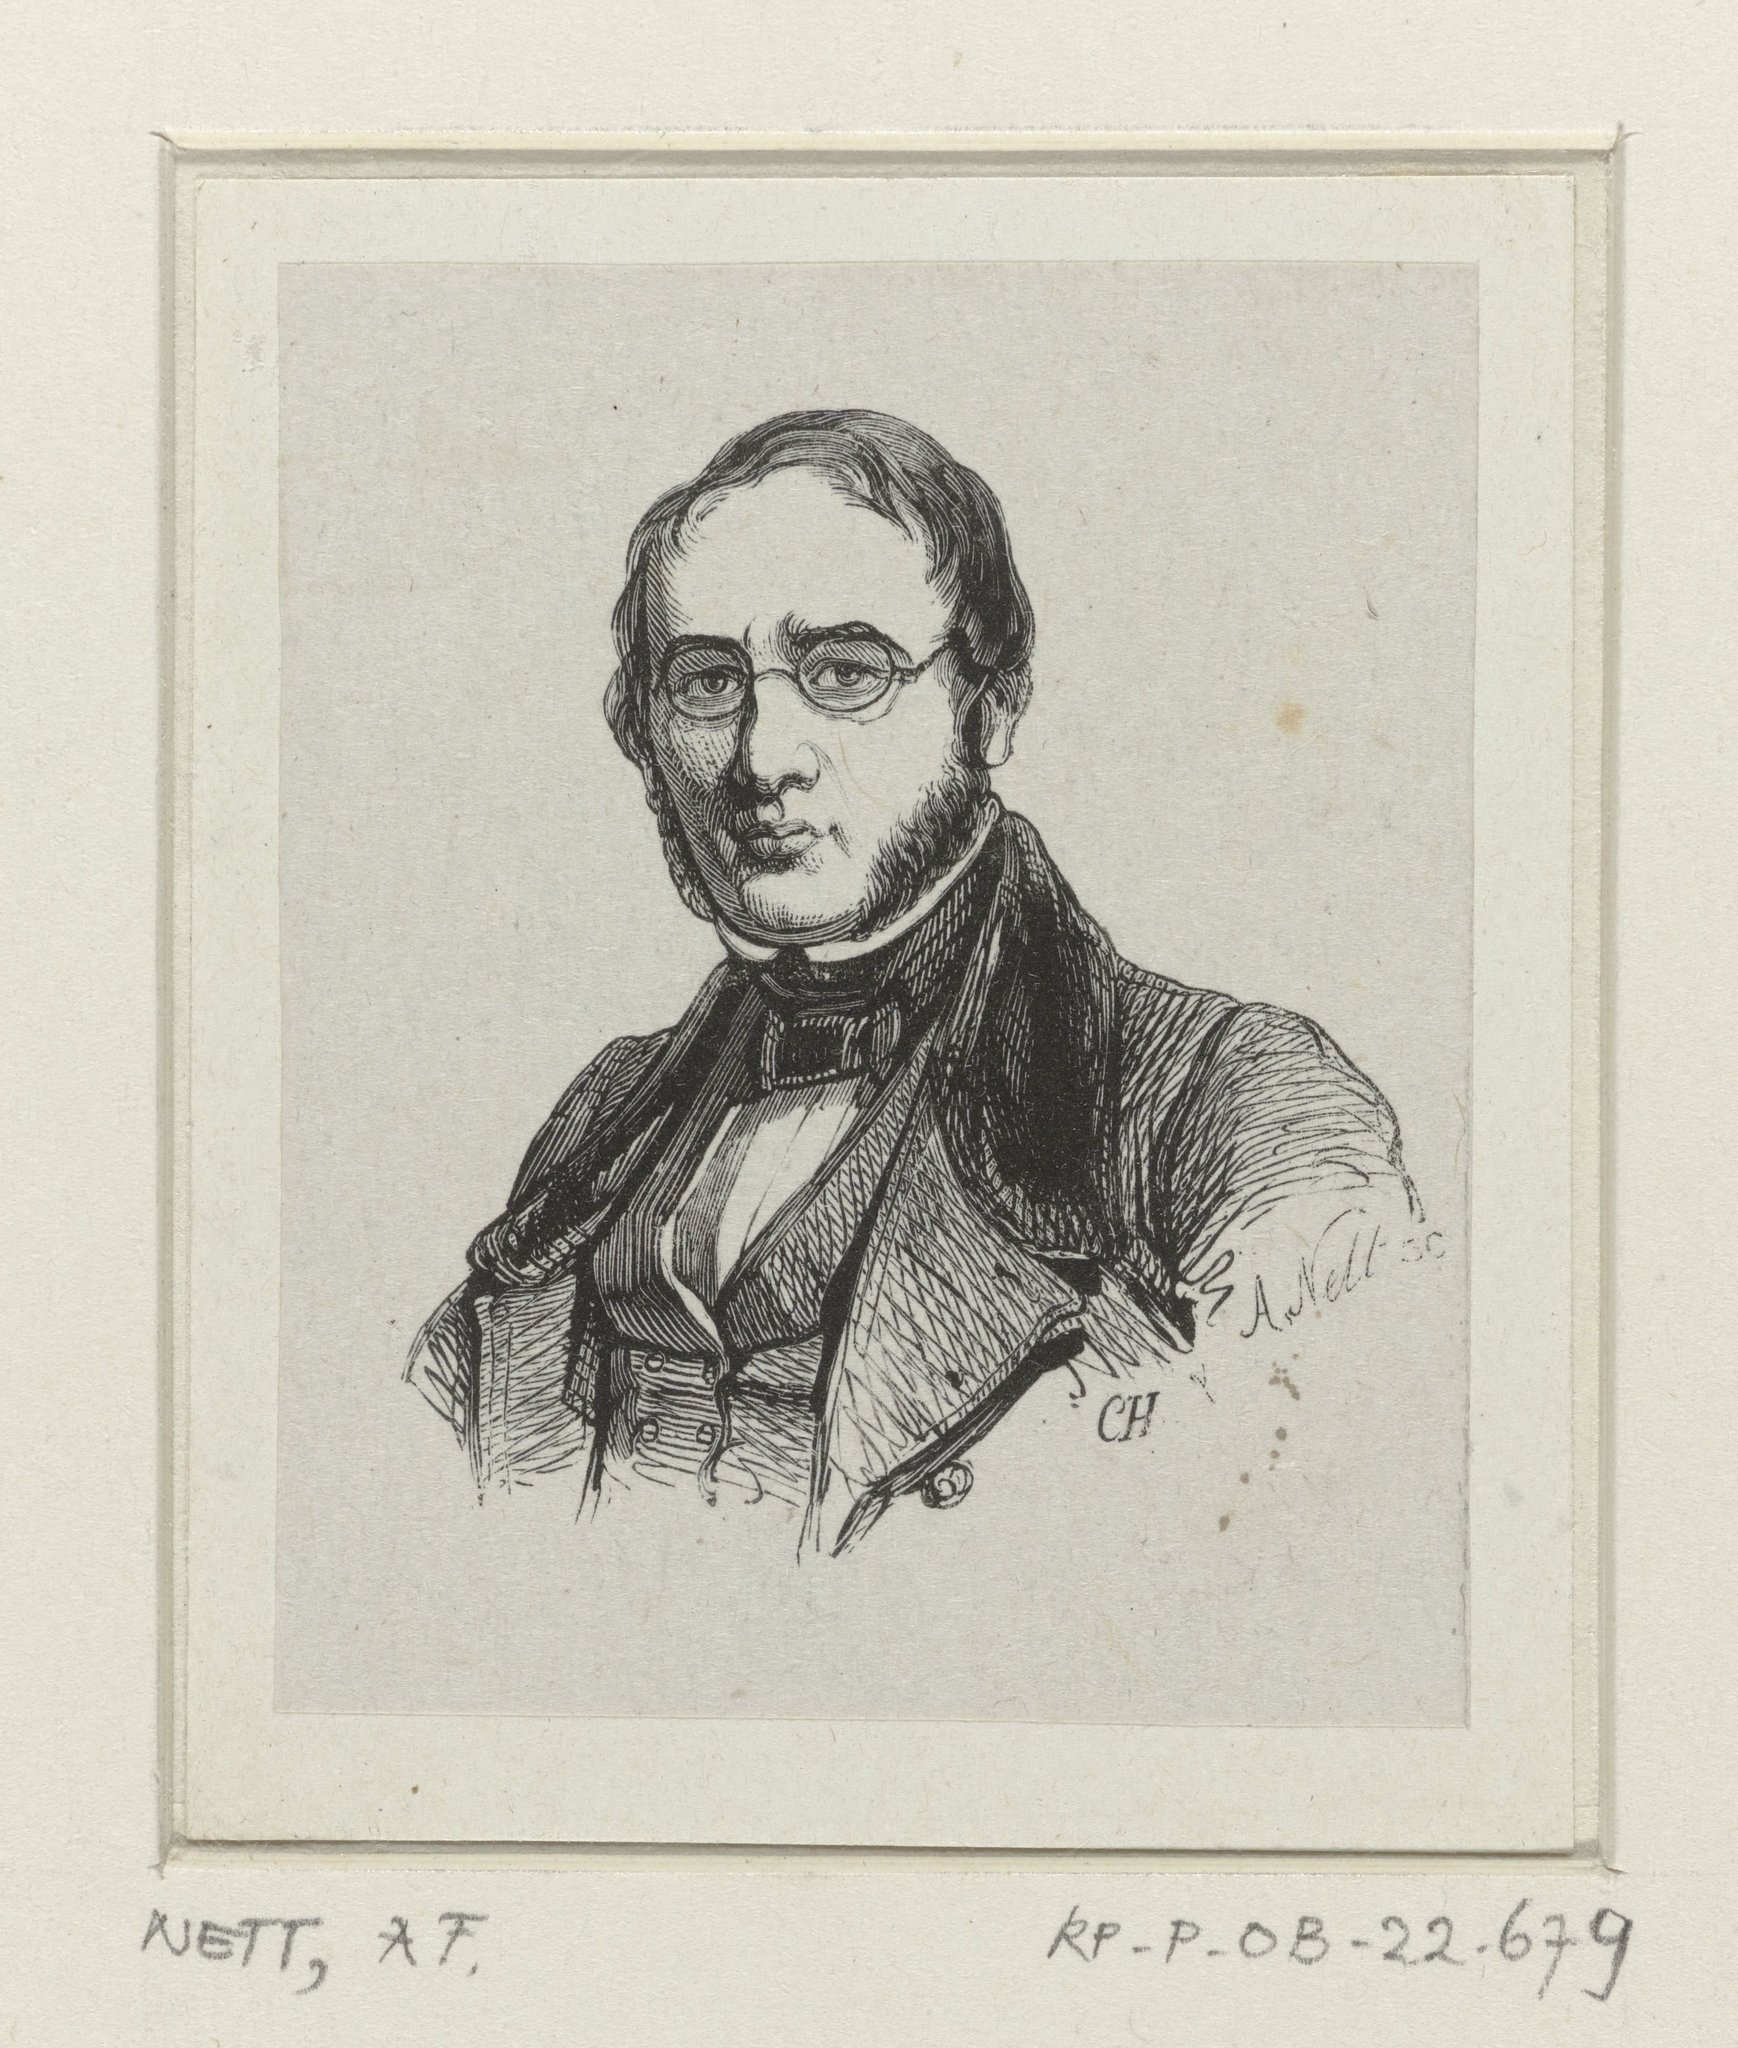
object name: print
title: Portret van André Benoit Barreau Taurel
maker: adolphe frédéric nett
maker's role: print maker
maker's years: 1822-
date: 1832-1900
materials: paper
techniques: engraving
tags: paris, amsterdam, print maker, draughtsman, benoit taurel, historical persons, portrait, self-portrait of artist, portrait, self-portrait of graphic artist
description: Portret van de graveur en etser André Benoit Barreau Taurel.